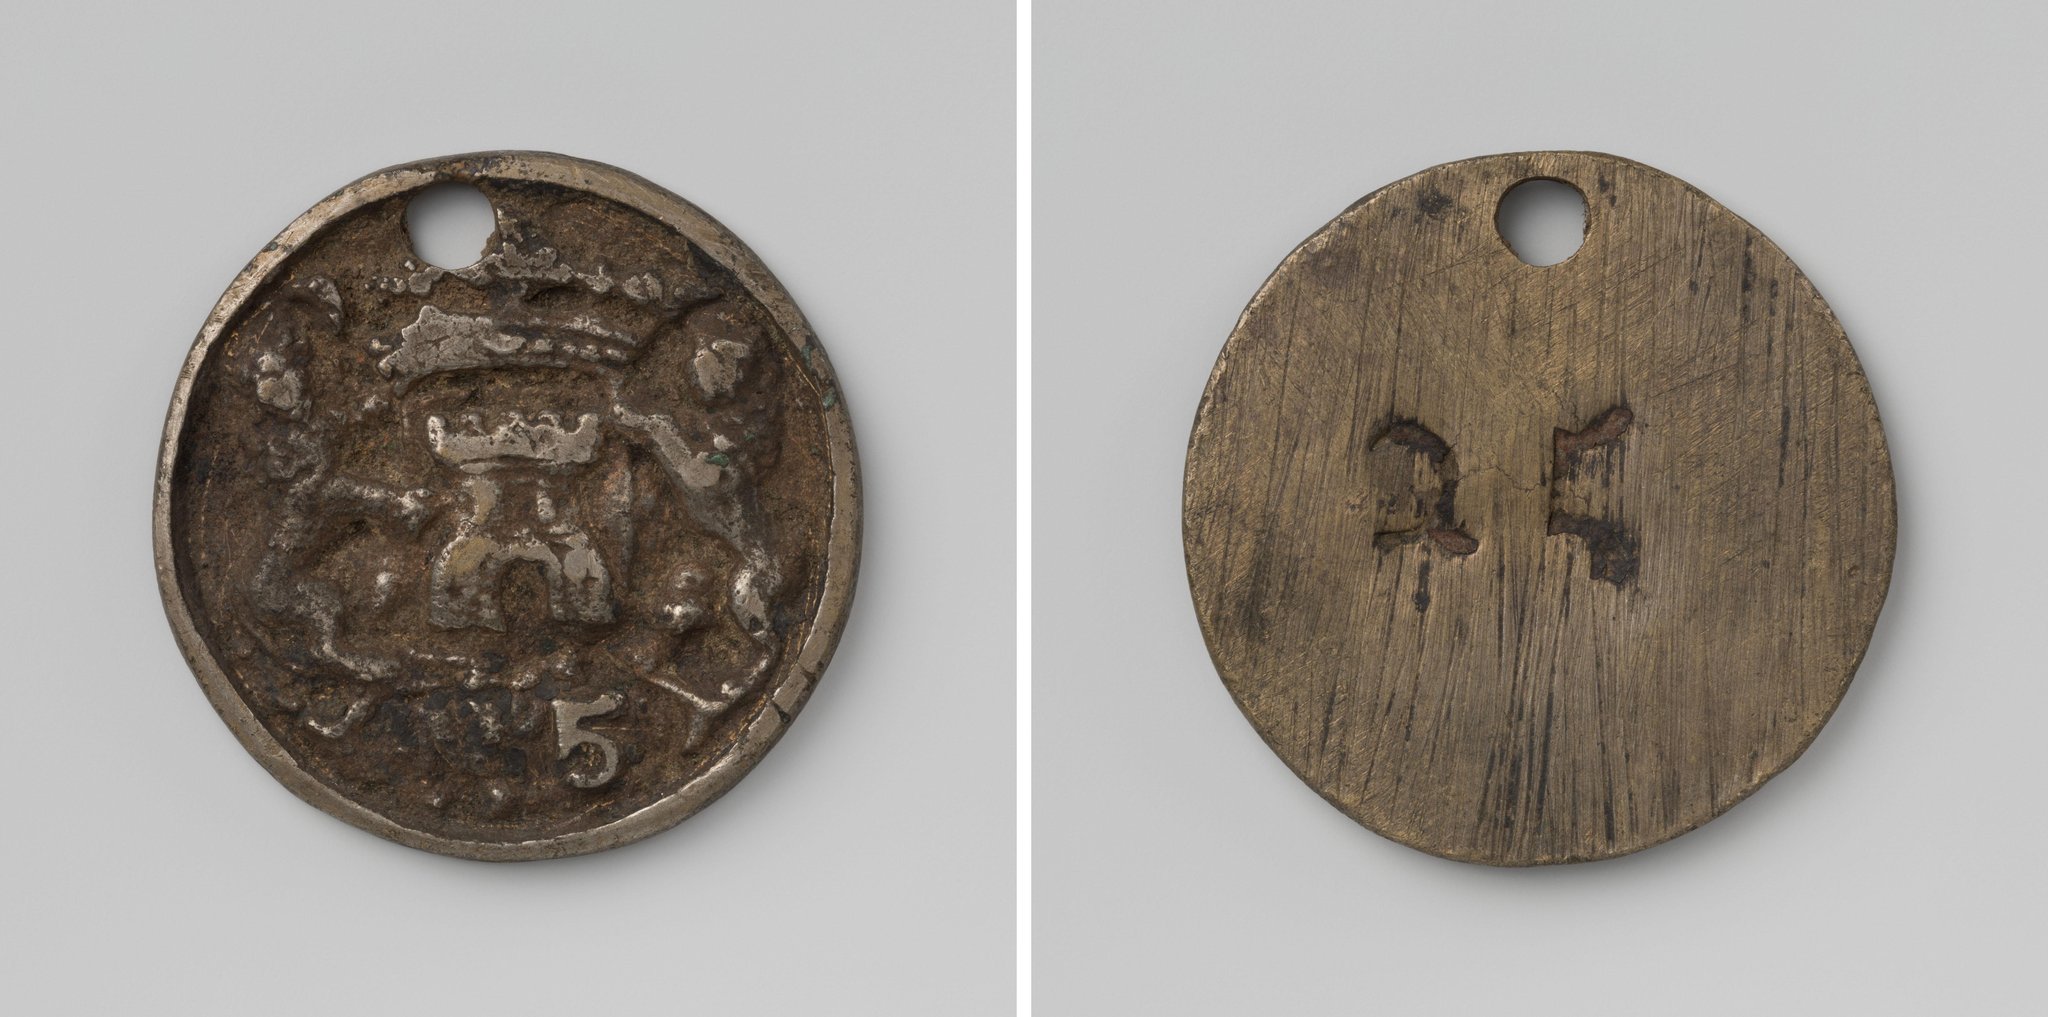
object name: medal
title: Alkmaar, brandspuitpenning van spuit 5 met no. 25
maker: Anonymous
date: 1680-1800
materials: brass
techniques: casting, engraving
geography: alkmaar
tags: alkmaar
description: Messing penning met gat erin. Voorzijde: gekroond wapenschild, geflankeerd door twee leeuwen boven cartouche met cijfer No. 5. Keerzijde: cijfer 25